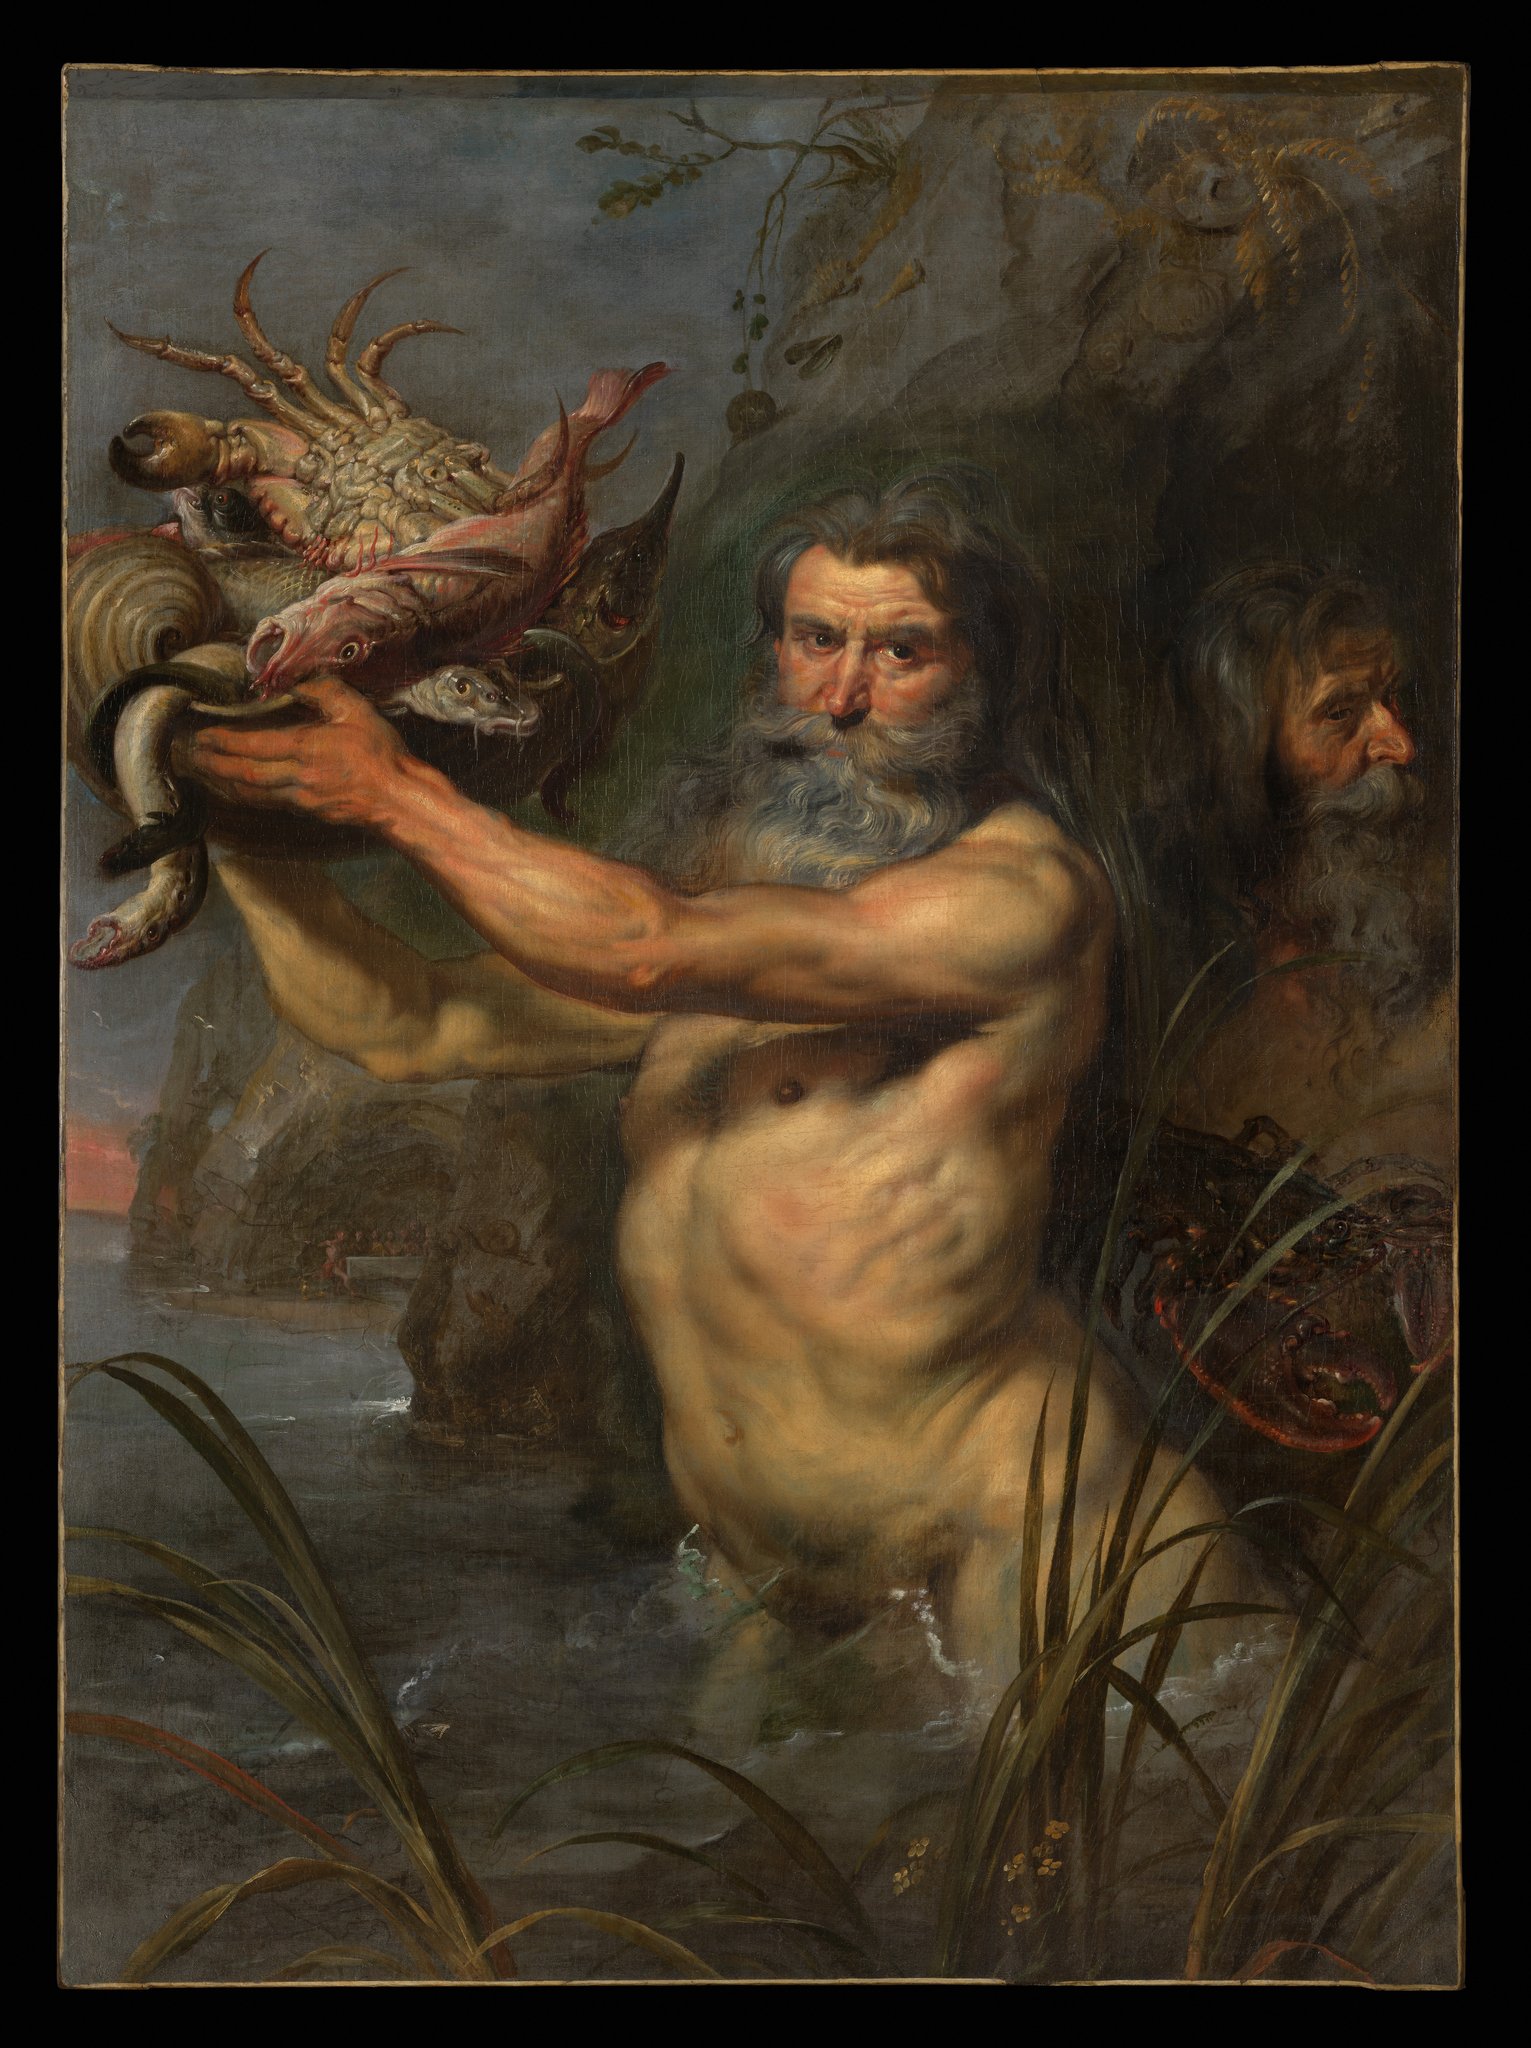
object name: painting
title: Two Tritons at the Feast of Acheloüs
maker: anthony van dyck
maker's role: artist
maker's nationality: flemish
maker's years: 1599-1641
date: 1603-1651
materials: canvas, oil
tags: men,triton,crabs